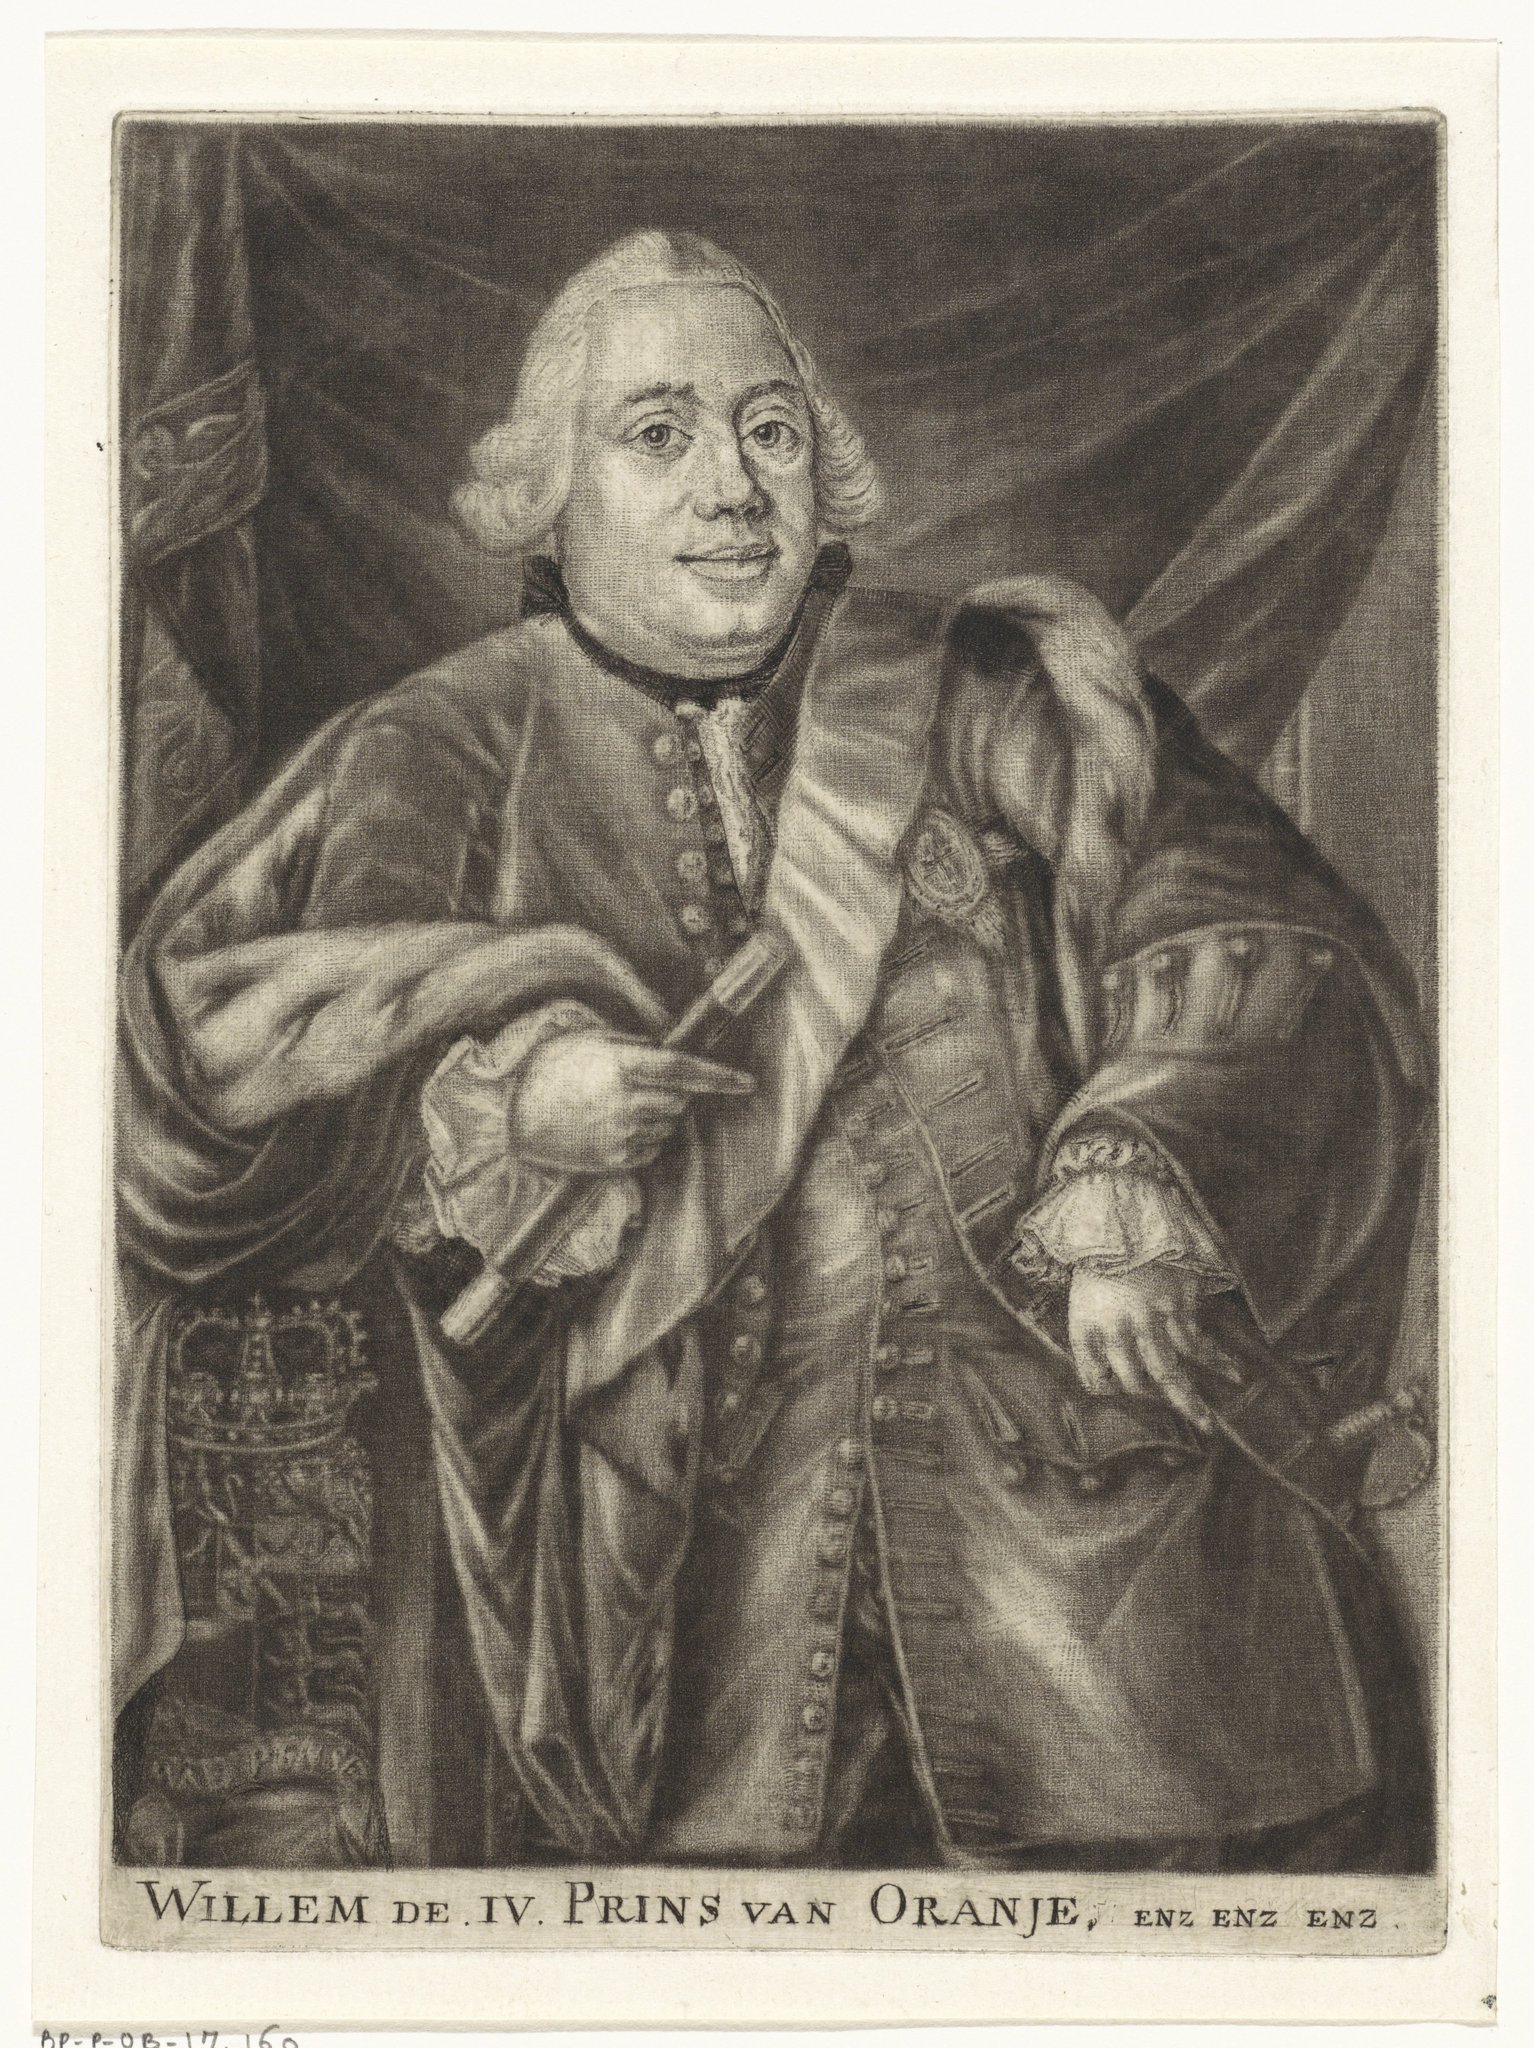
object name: print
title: Portret van Willem IV, prins van Oranje-Nassau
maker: johannes de groot (ii)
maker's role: painter, print maker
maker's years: 1688-1796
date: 1698-1776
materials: paper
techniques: engraving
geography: northern netherlands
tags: willem iv (prins van oranje-nassau)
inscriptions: collector's mark: Lugt 2228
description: Willem IV, prins van Oranje-Nassau. In zijn hand de regeerderstaf en naast hem de kroon.